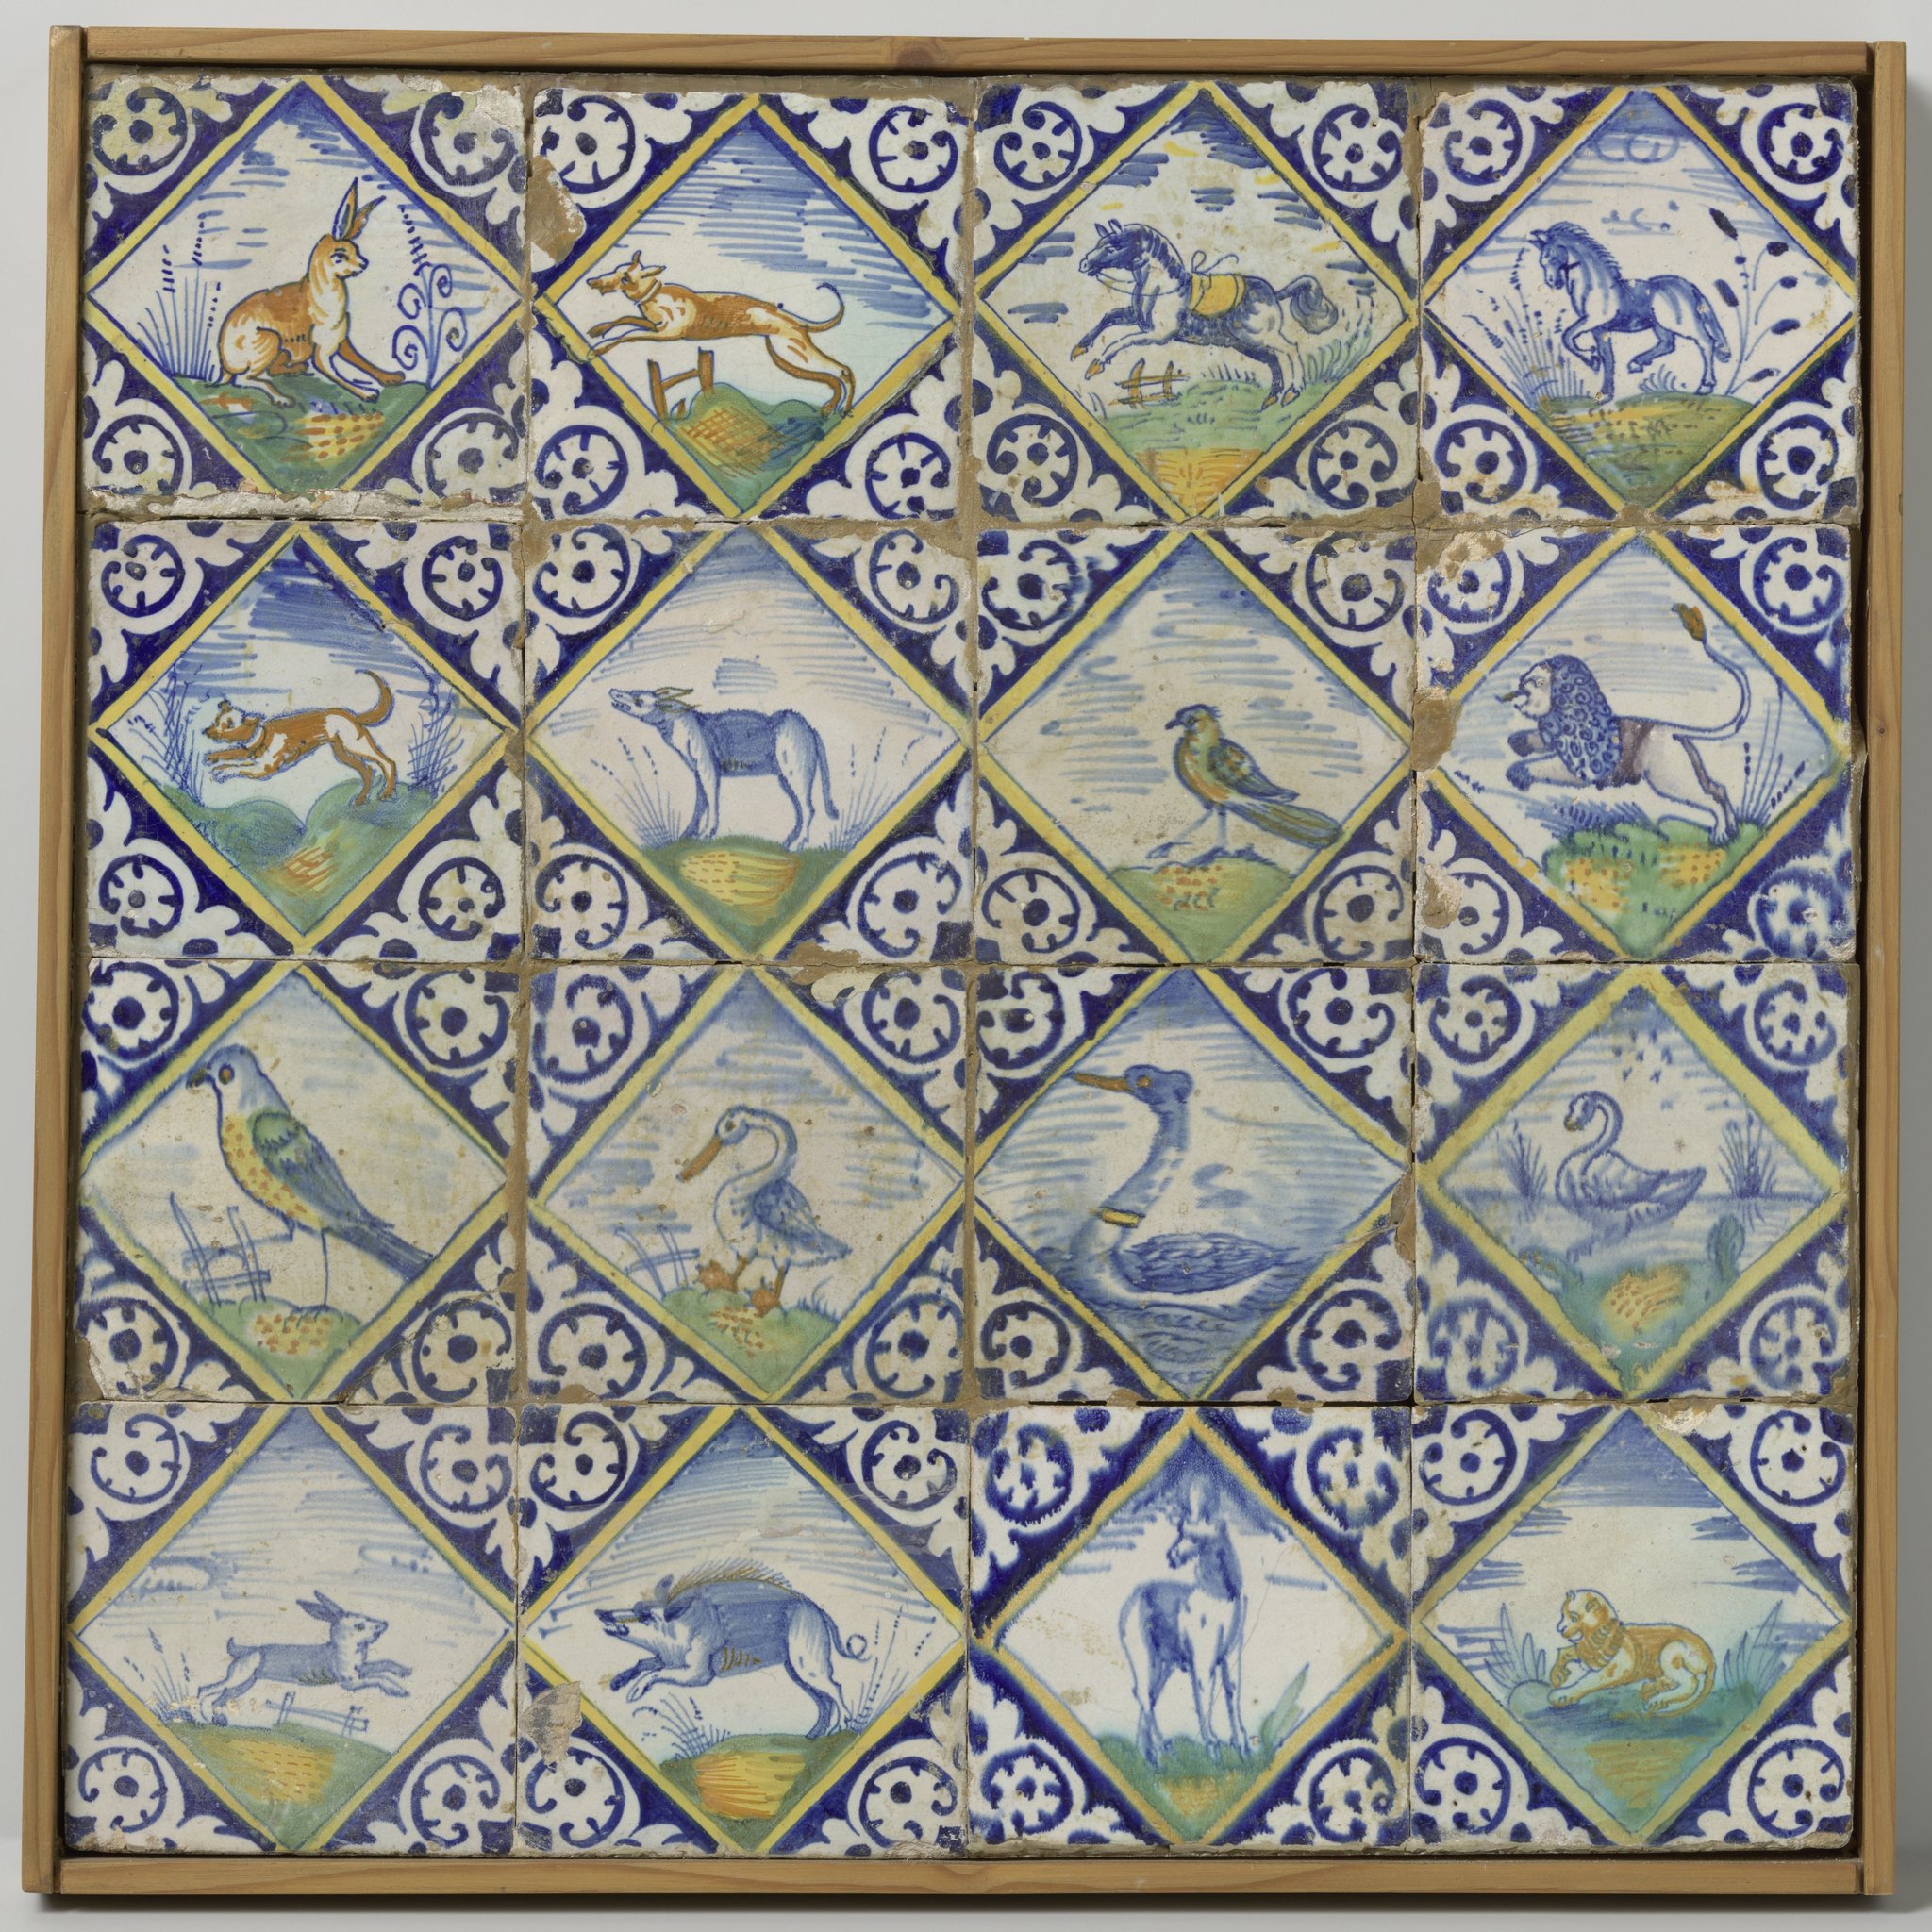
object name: tile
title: Veld van zestien tegels met dieren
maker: Anonymous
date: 1580-1625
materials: earthenware, glaze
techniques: maiolica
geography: netherlands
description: Veld van zestien tegels (4 x 4) elk met een veelkleurig (blauw, oranje, geel, groen en paars) geschilderd dier binnen een kwadraat. In de hoeken, vultechniek ornament.